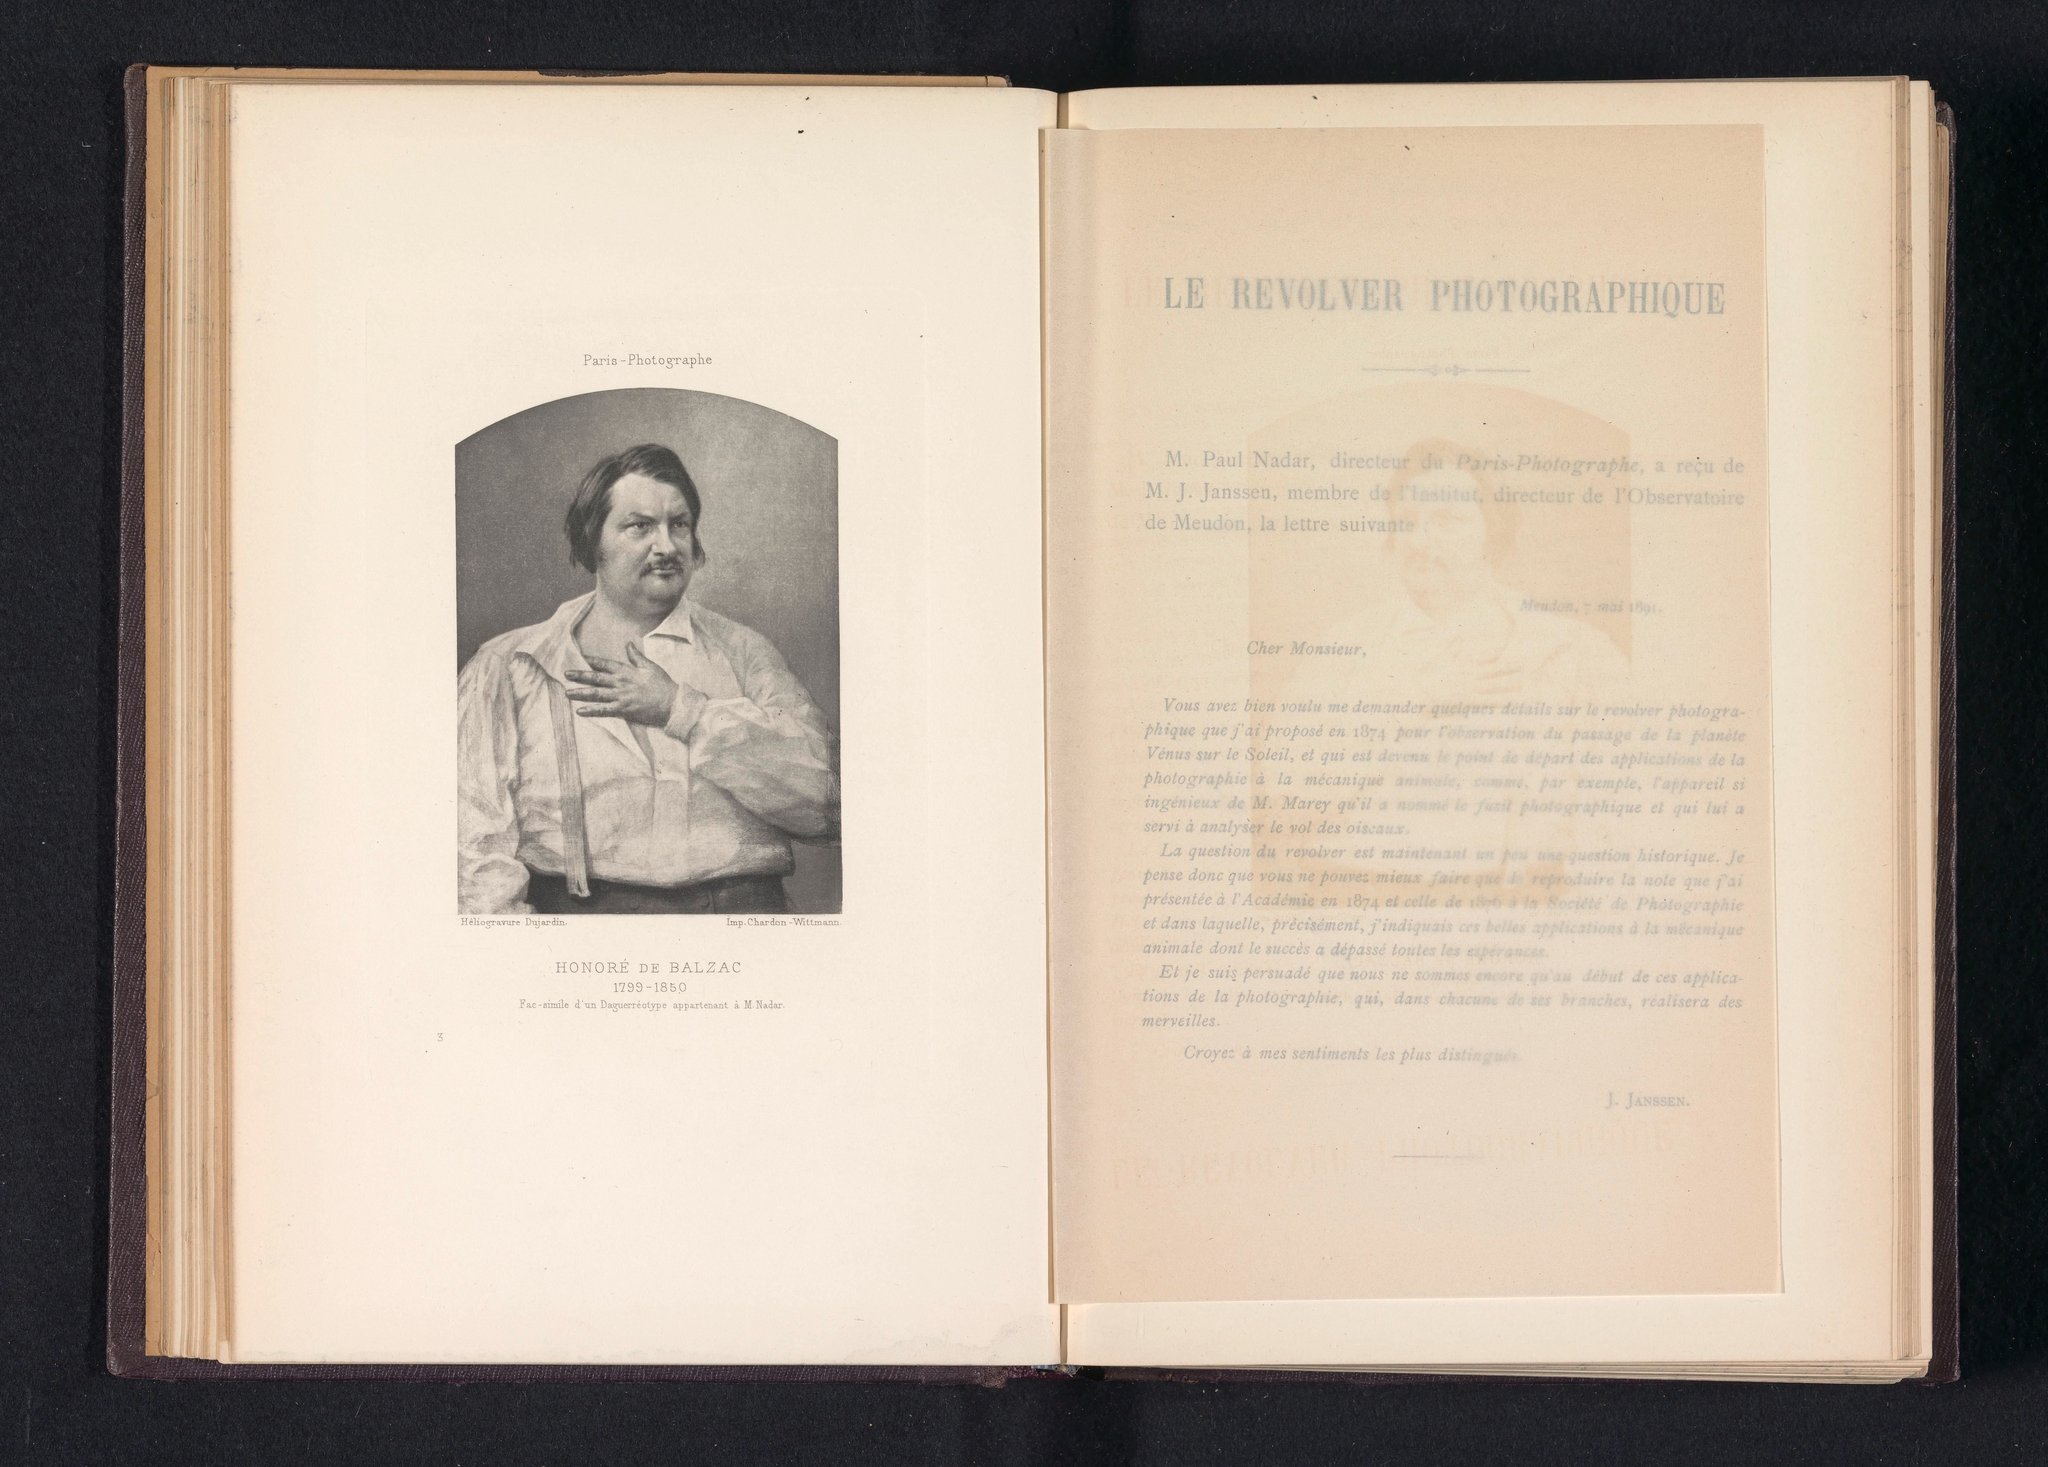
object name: page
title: Fotoreproductie van een portret van Honoré de Balzac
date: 1881-1891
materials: paper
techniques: photoaquatint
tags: paris, honoré de balzac, portrait of a writer